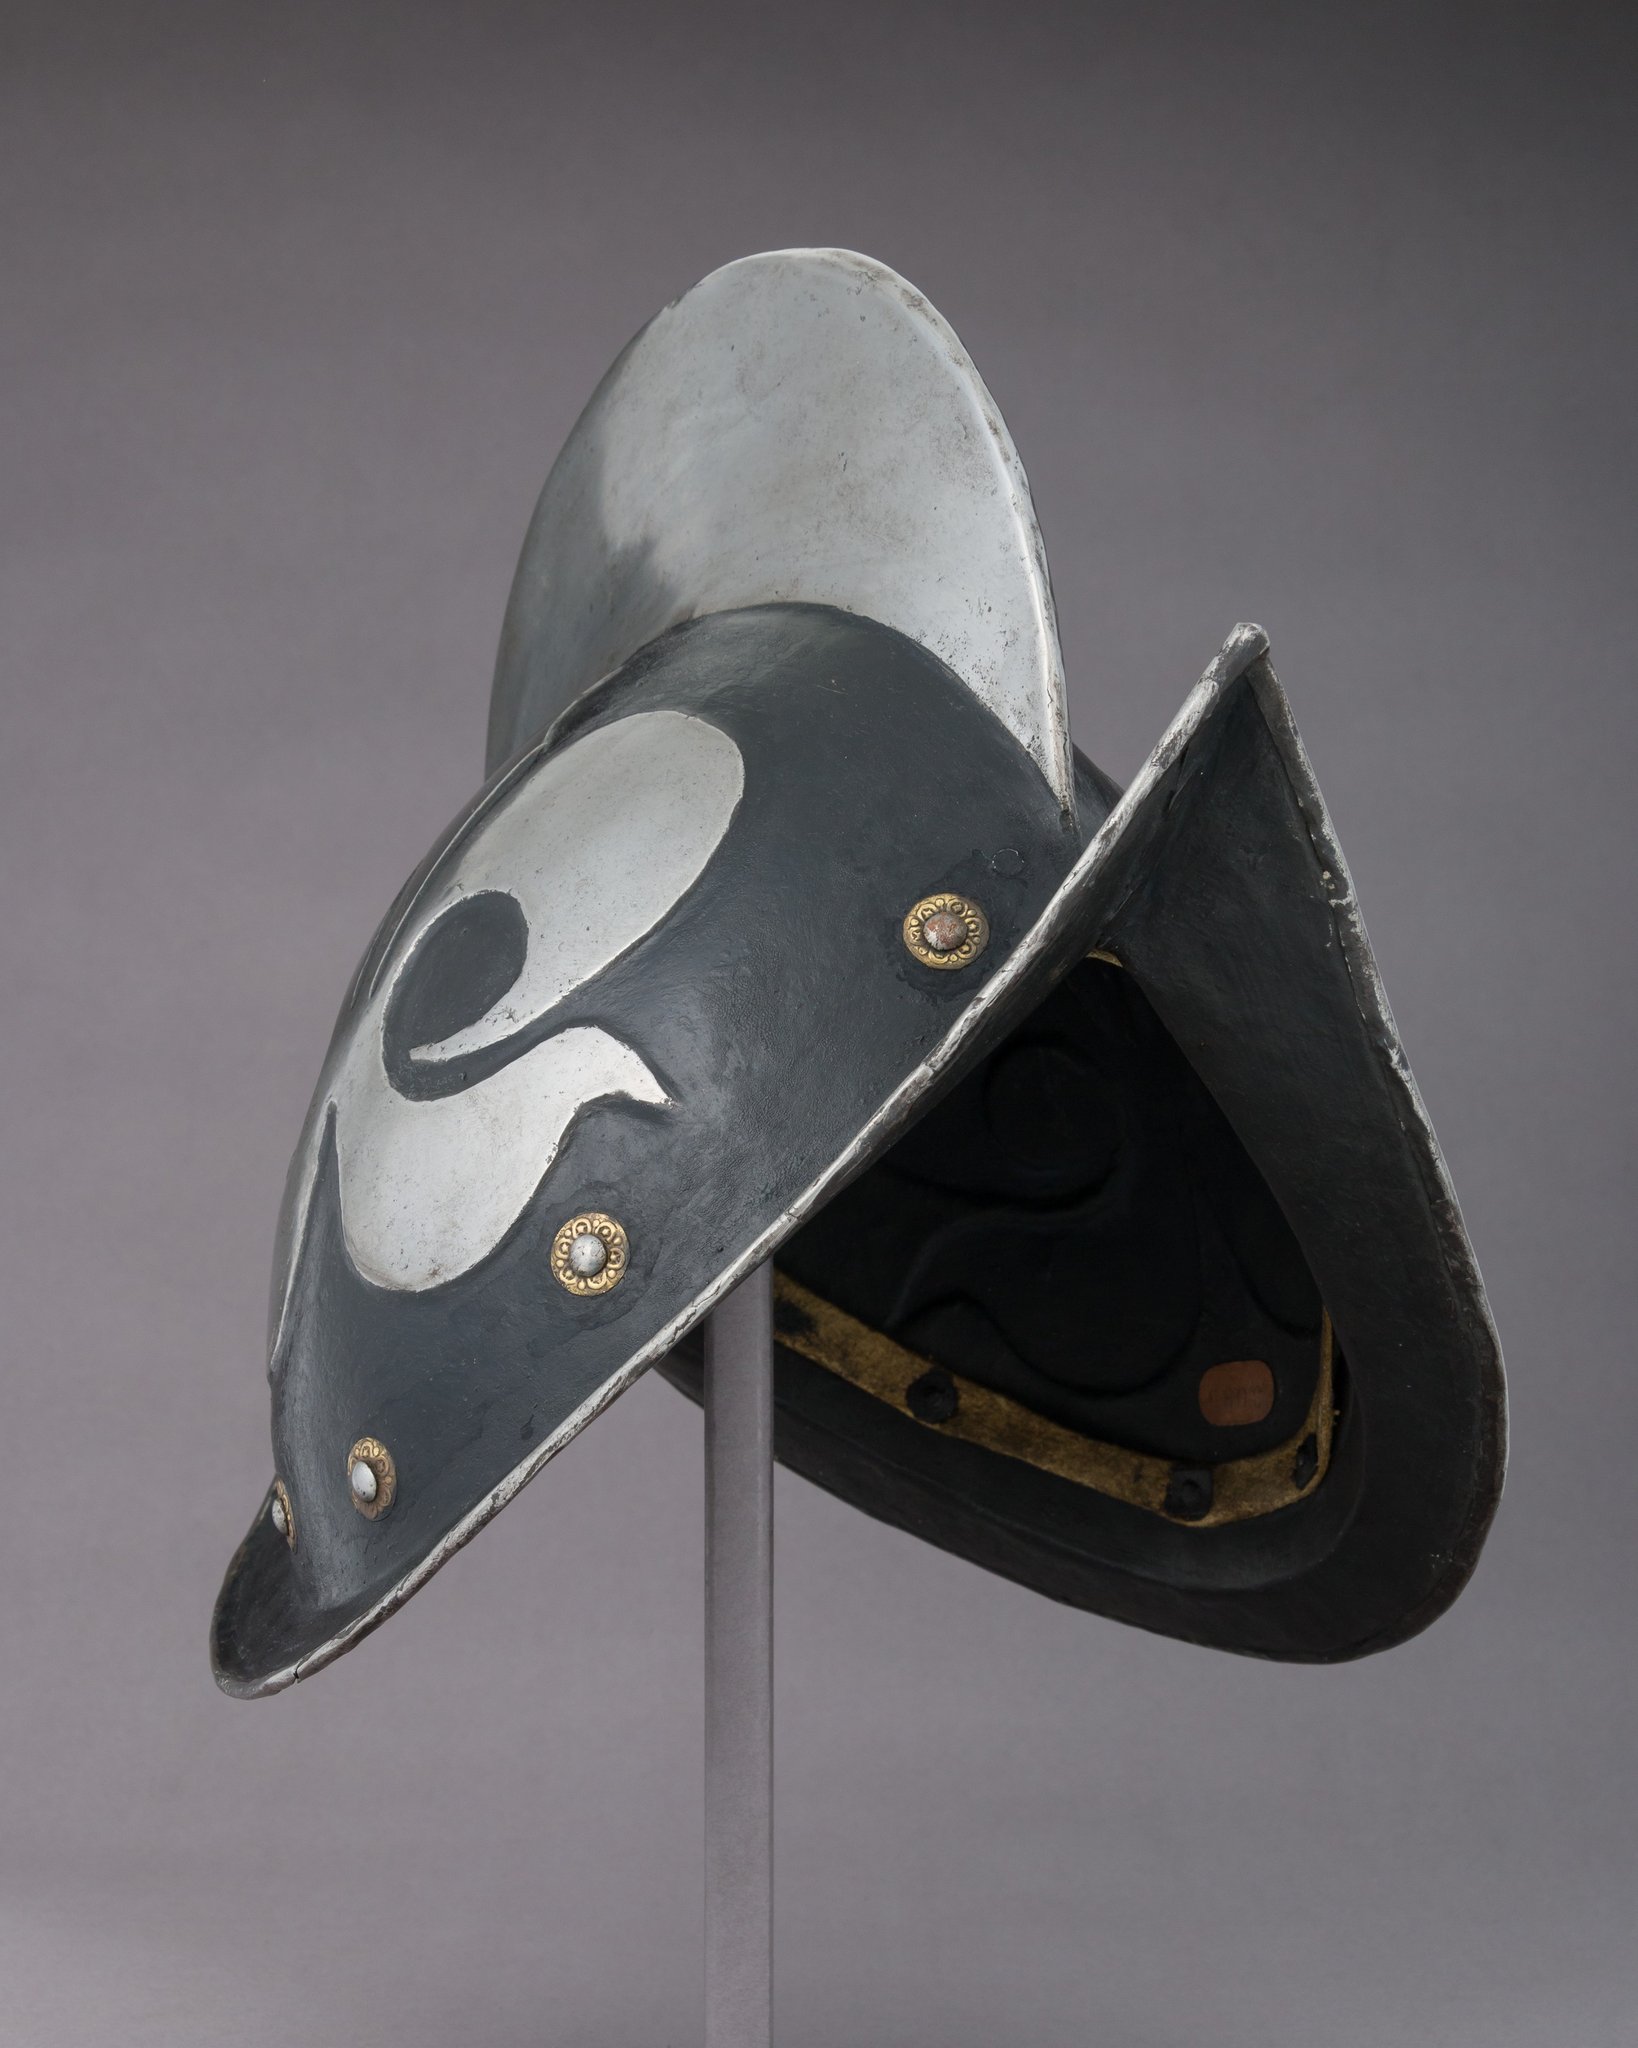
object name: morion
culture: german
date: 1567-1600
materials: brass, leather, steel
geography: germany